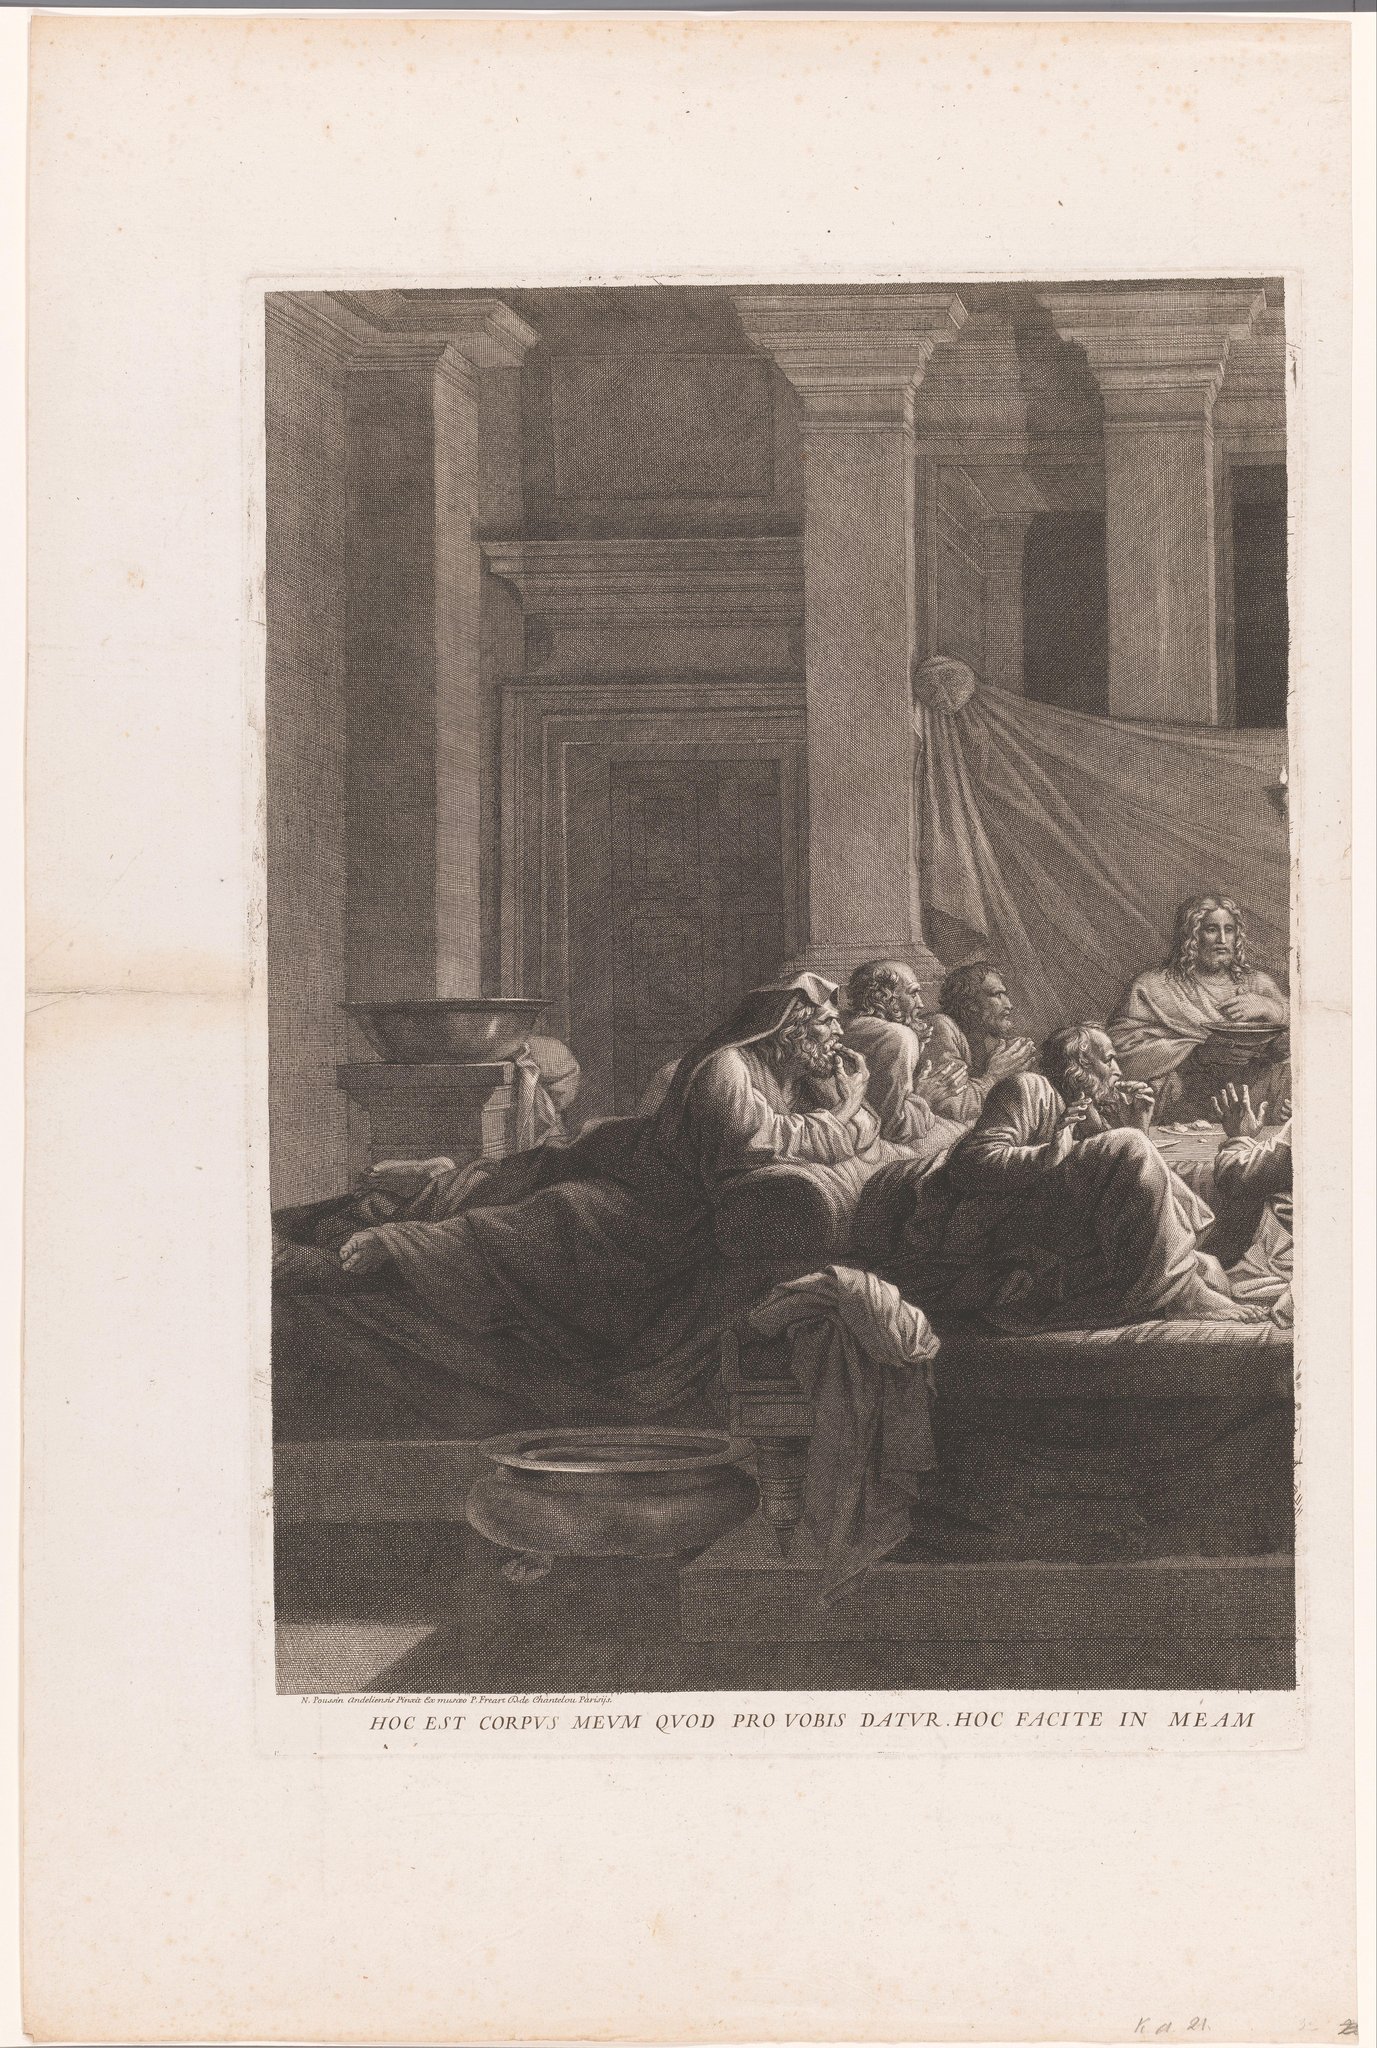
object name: print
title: Laatste Avondmaal (linker deel)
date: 1680-1694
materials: paper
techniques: etching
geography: france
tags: the eucharist ~ the fourth of the seven sacraments, institution of the eucharist, i.e. christ showing or blessing bread (host) and/or wine (matthew 26:26-27; mark 14:22-23; luke 22:19-20; john 13:26; 1 corinthians 11:23-25)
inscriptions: collector's mark: Lugt 240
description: Prent maakt deel uit van een ongenummerde serie van zeven prenten.